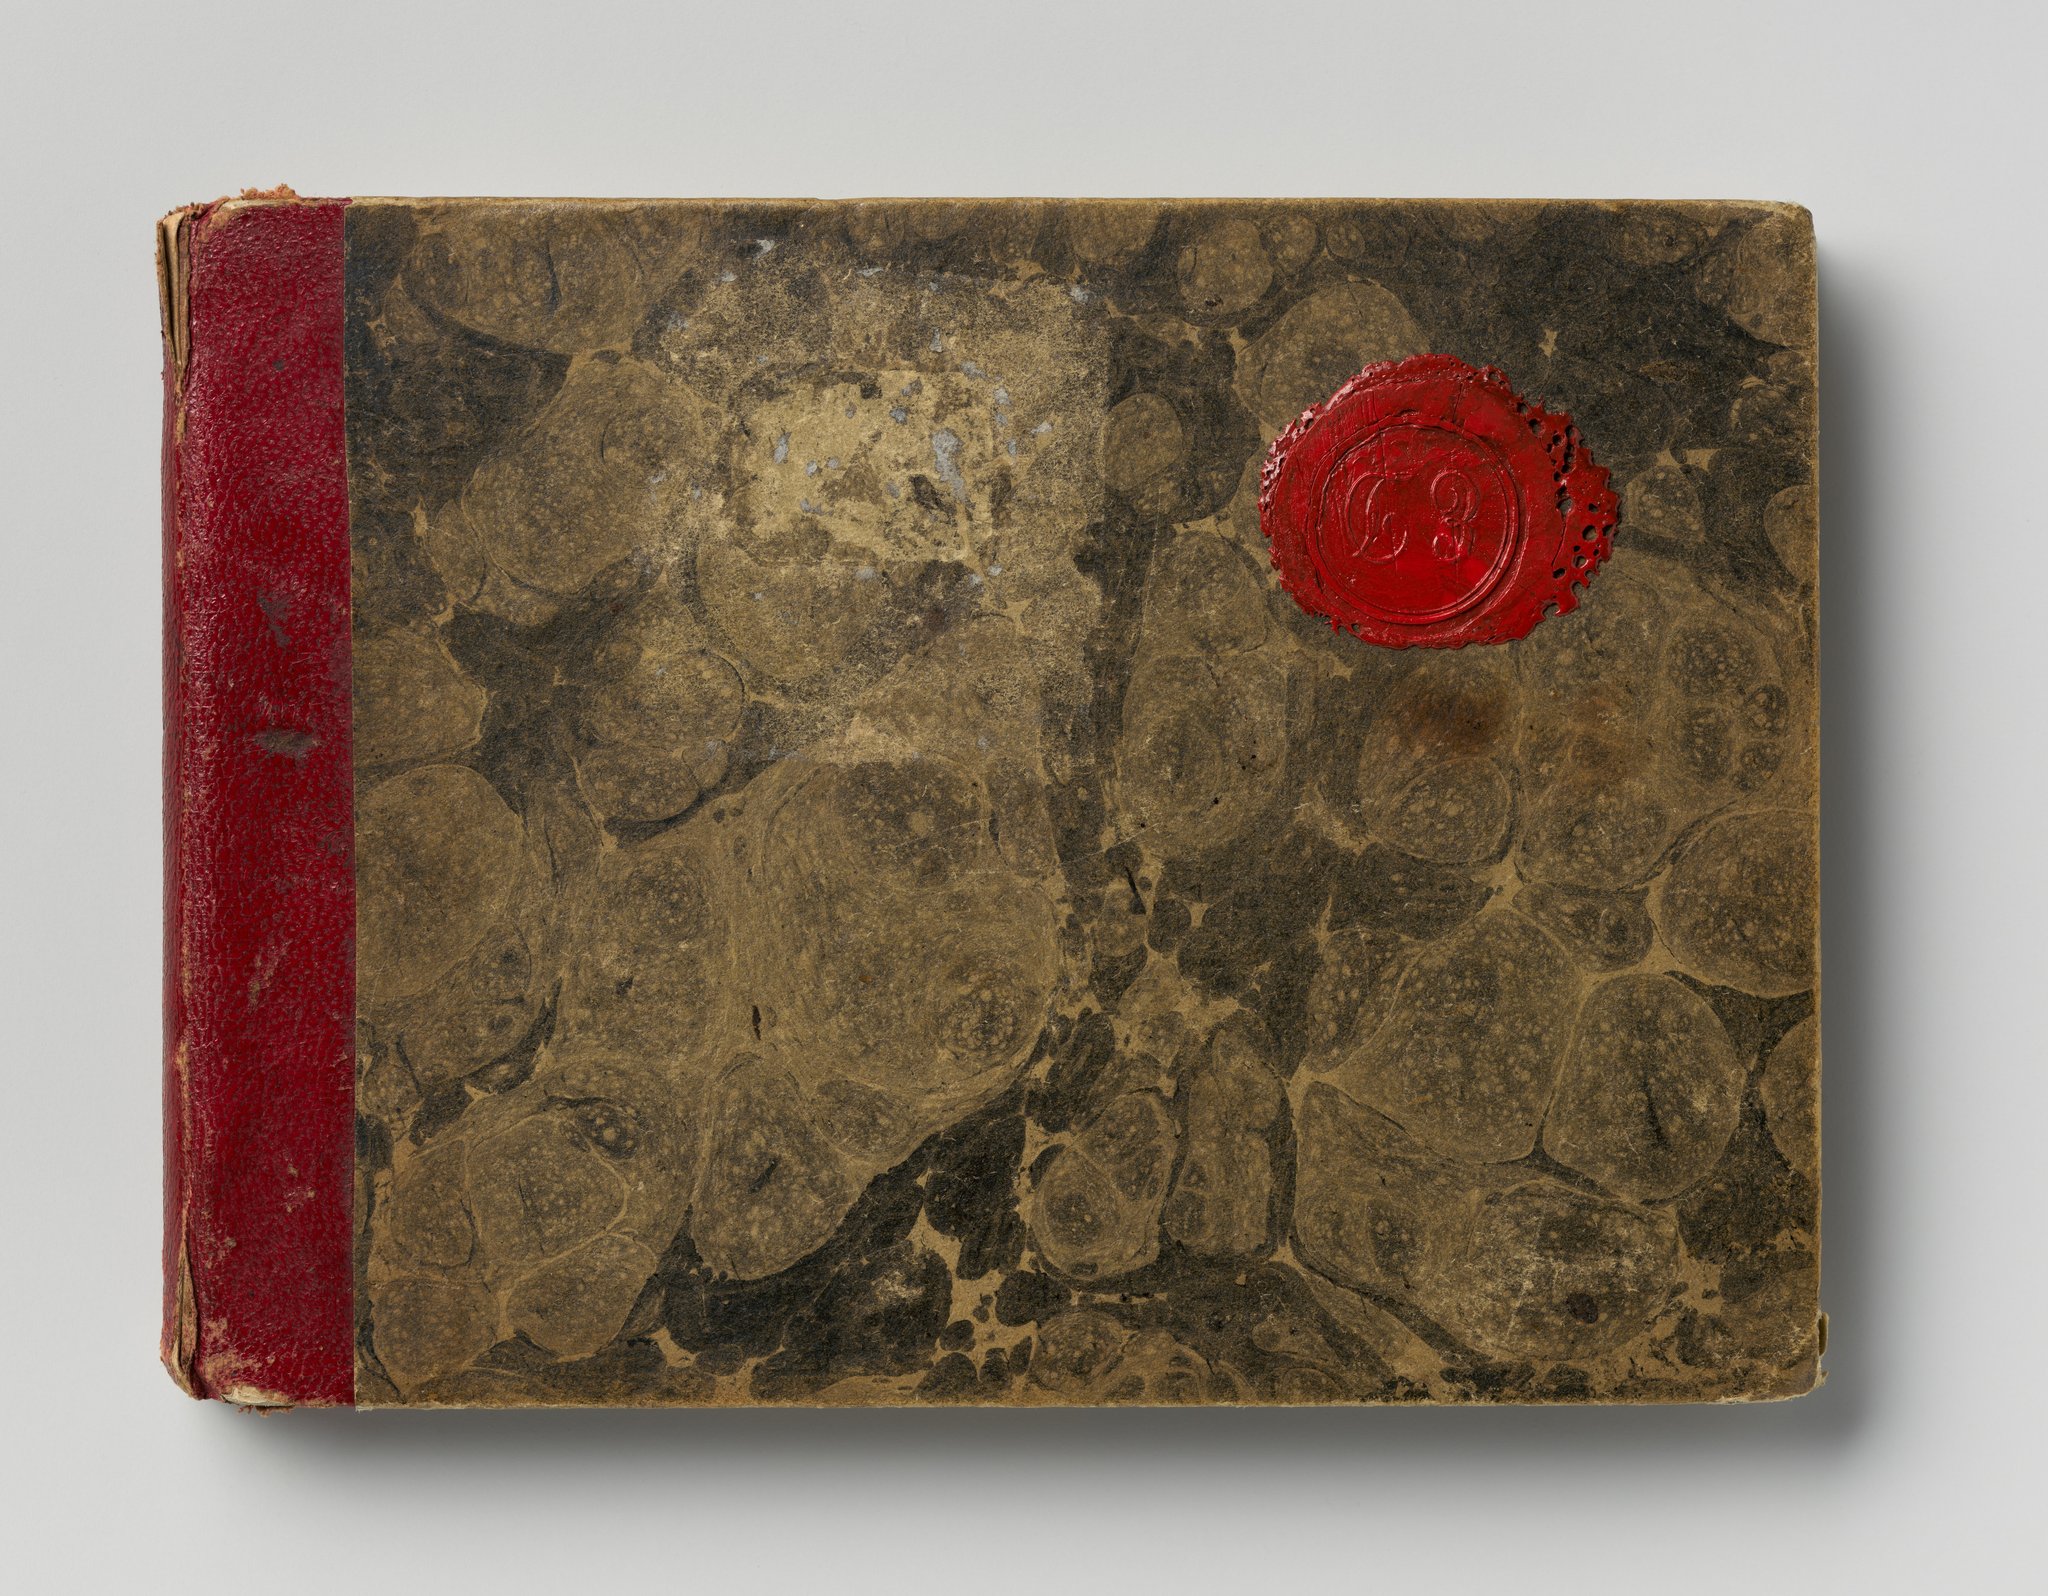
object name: drawing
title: Normandy Sketchbook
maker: eugène delacroix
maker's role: artist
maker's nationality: french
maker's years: 1798-1863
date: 1829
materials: graphite, watercolor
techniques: bookbinding